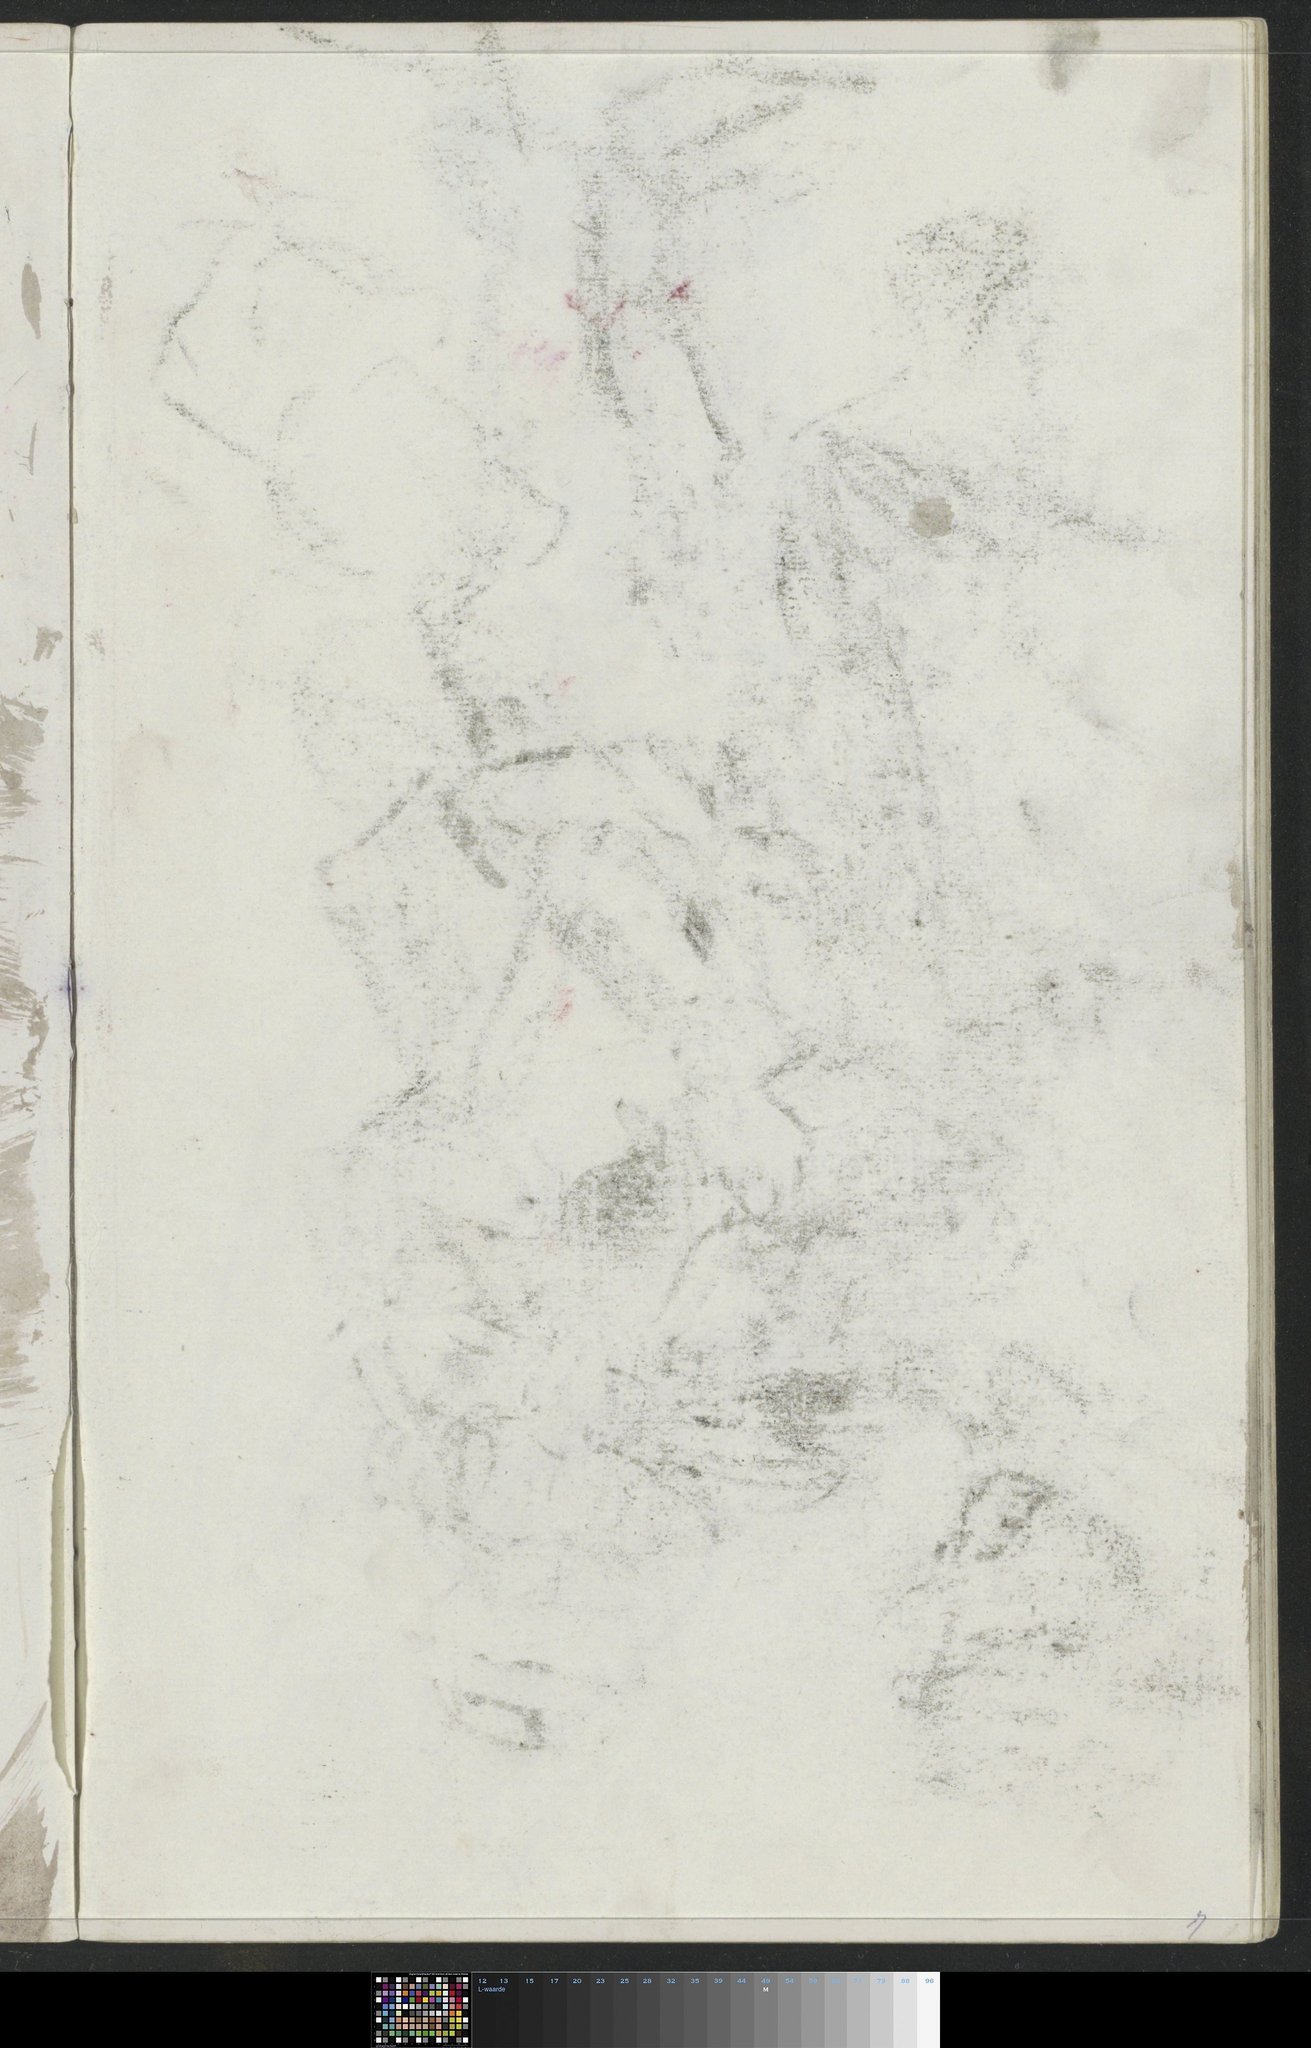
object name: sketchbook leaf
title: Abklatsch van de krijttekening op blad 6 verso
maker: isaac israels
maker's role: draughtsman, painter, print maker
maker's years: 1865-1934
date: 1875-1934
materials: paper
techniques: printmaking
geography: amsterdam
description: Blad 7 recto uit schetsboek XI met 30 bladen.